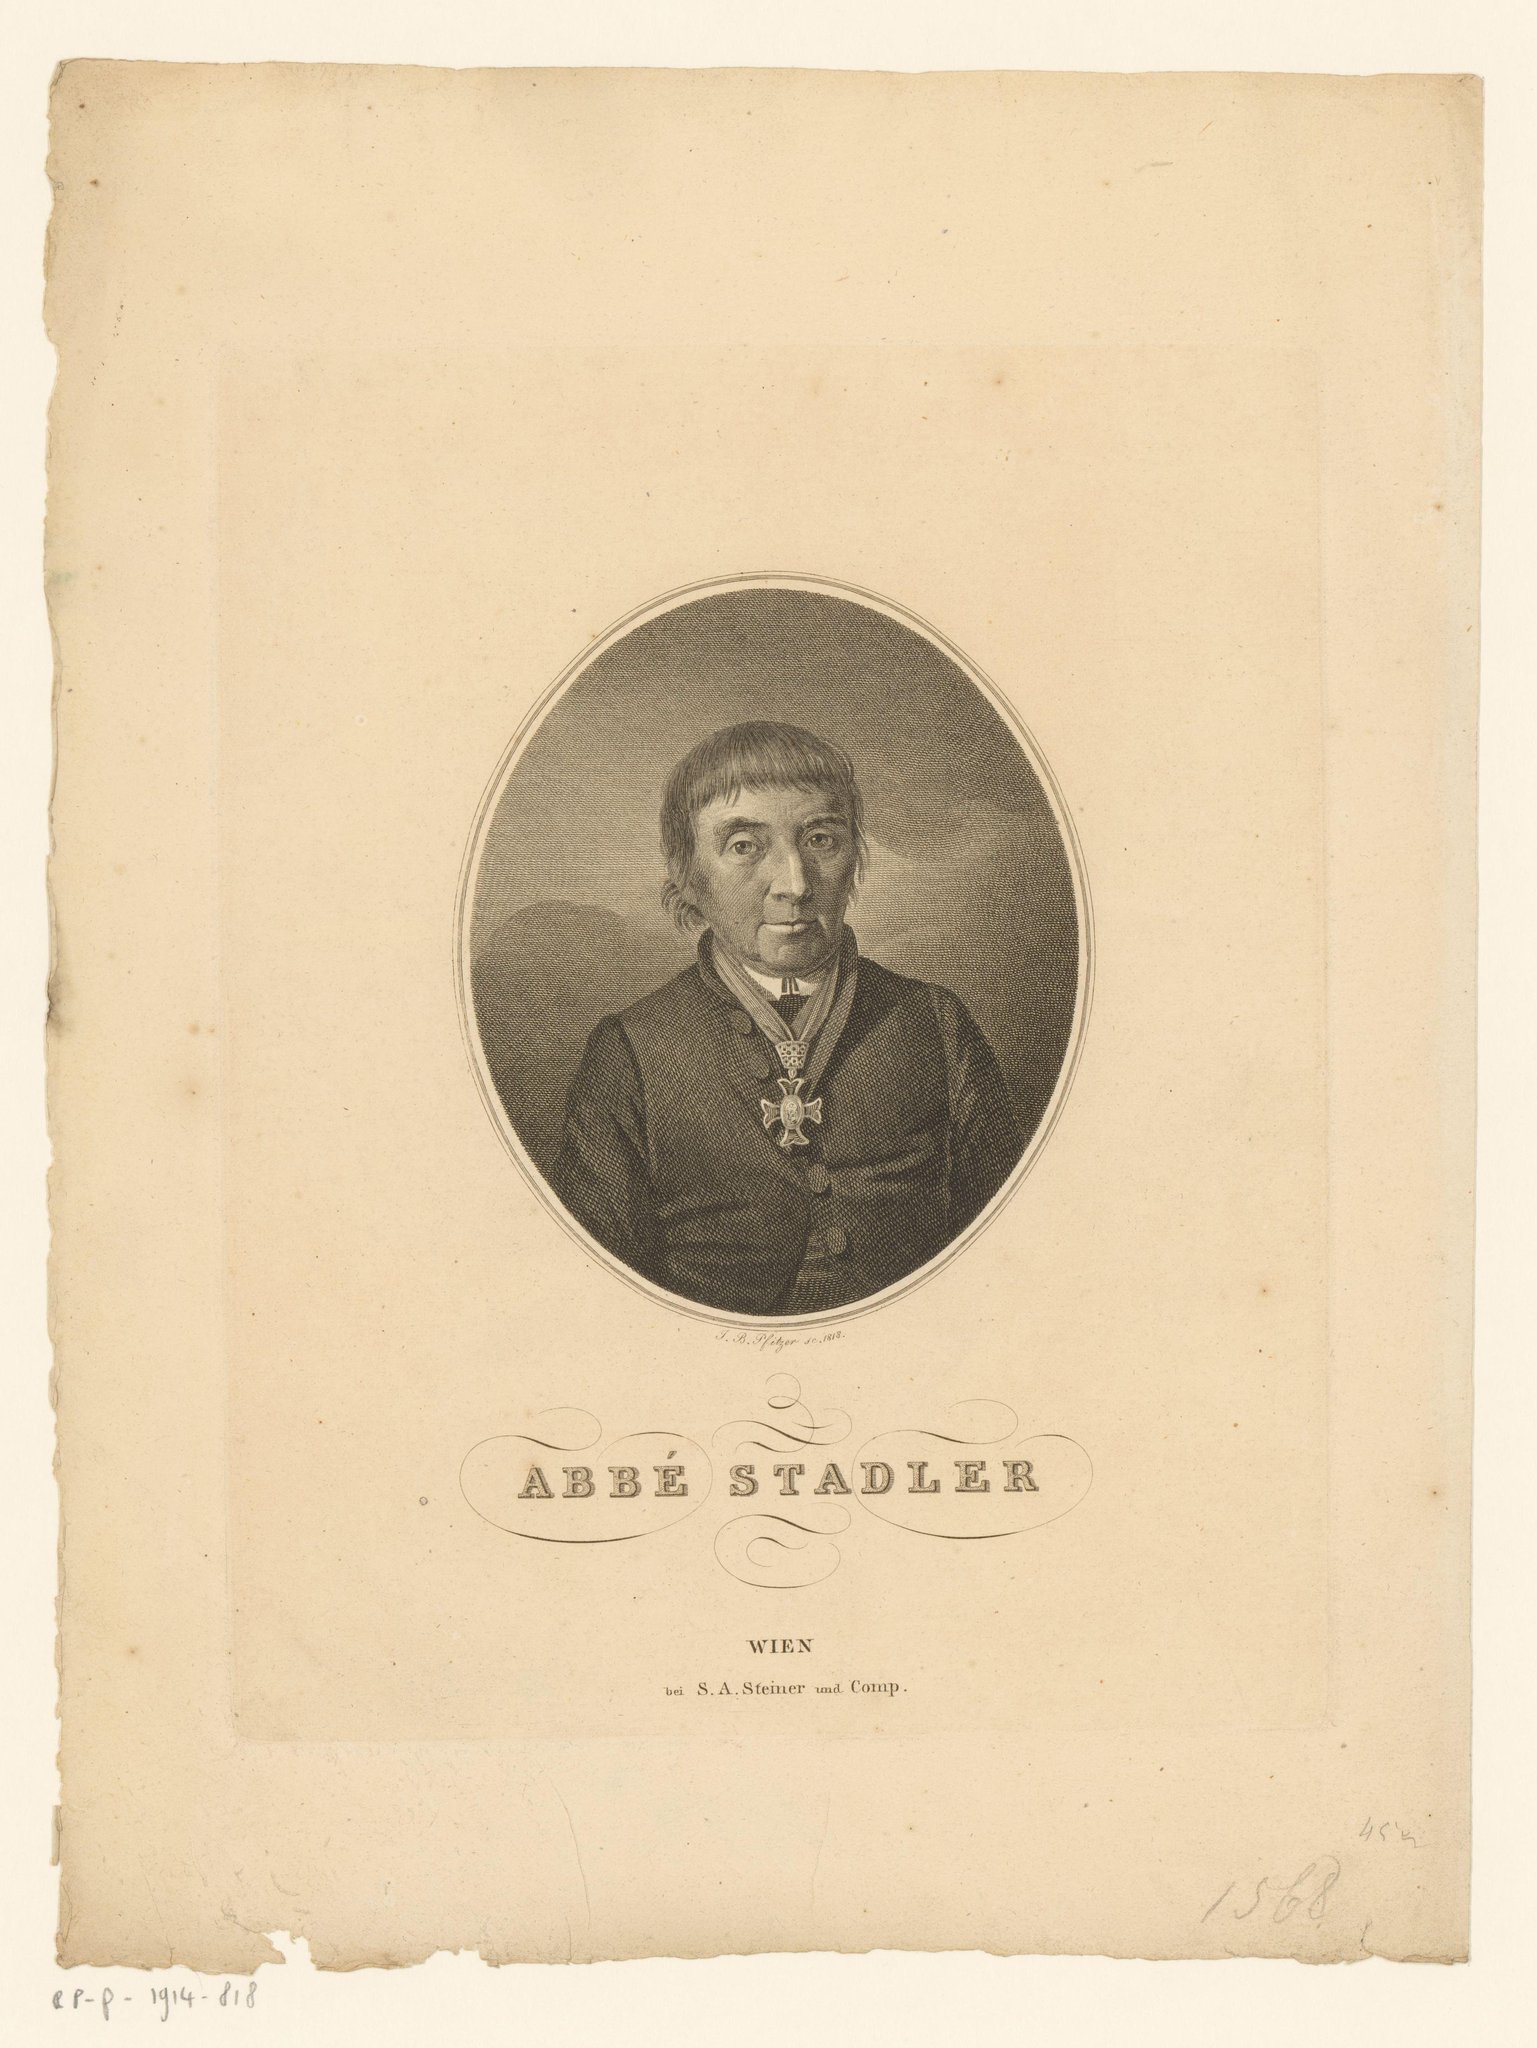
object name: print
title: Portret van Maximilian Stadler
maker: johann baptist pfitzer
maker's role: print maker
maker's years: 1789-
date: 1818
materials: paper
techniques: engraving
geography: vienna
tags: vienna, historical persons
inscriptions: collector's mark: Lugt 2228